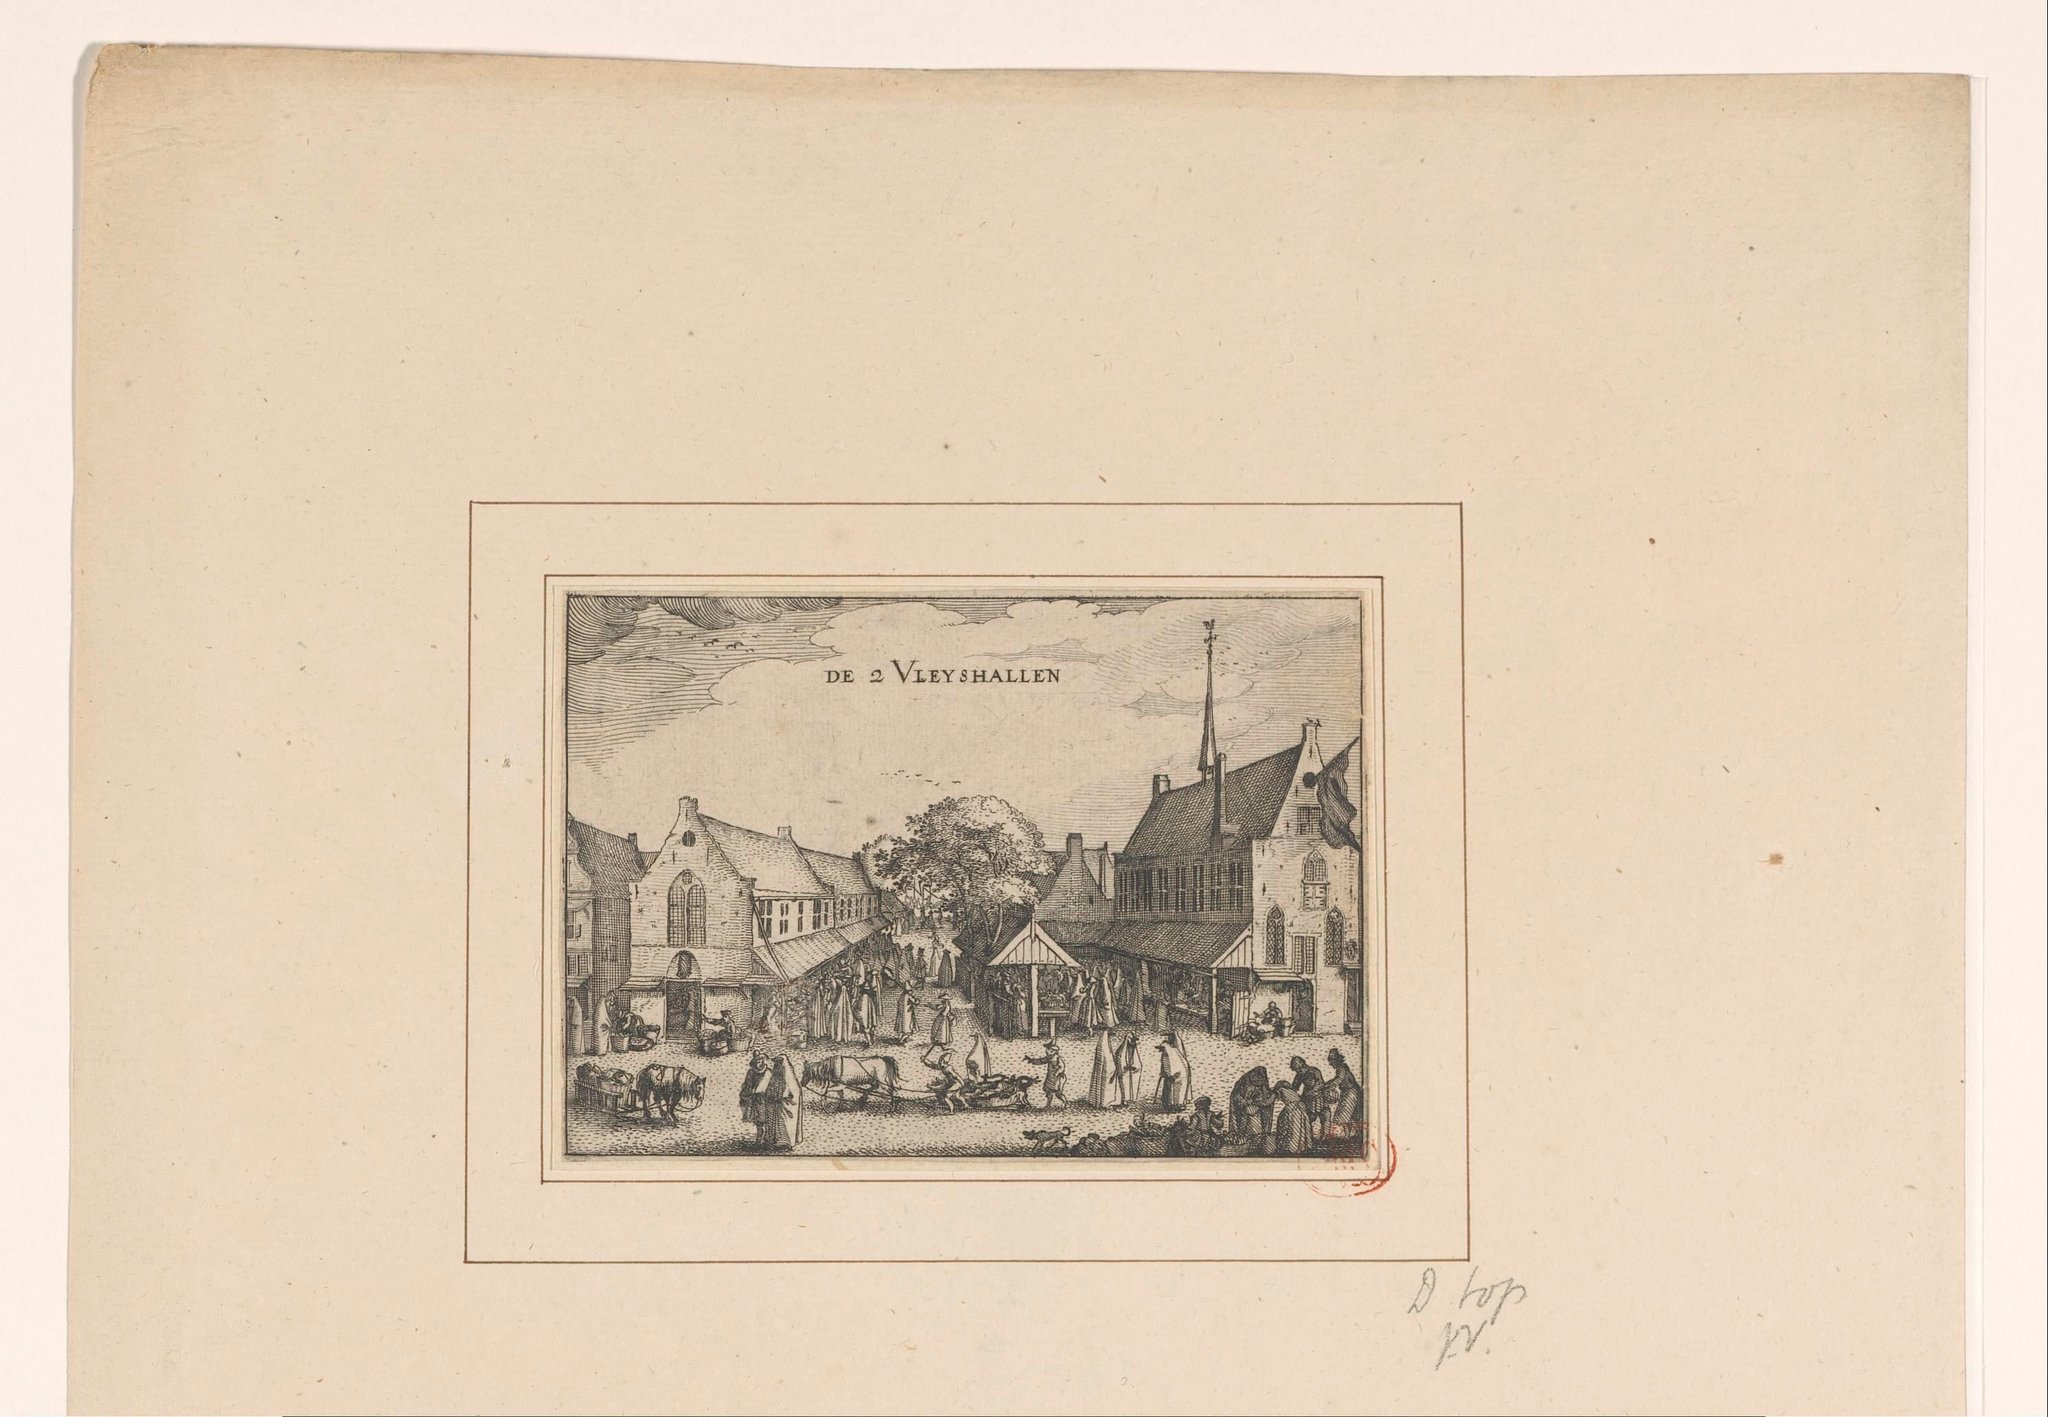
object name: print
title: Vier gebouwen in Amsterdam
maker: claes jansz. visscher (ii)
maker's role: draughtsman, print maker, publisher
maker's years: 1586-1652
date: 1611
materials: ink, paper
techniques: etching, pen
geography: amsterdam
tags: stall, booth (~ market), market, market-hall, street (+ city(-scape) with figures, staffage)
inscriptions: collector's mark: Lugt 195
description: Prent ook gebruikt als onderdeel van de rand van een profiel van Amsterdam, zie RP-P-AO-20-22. Let op: er is verwarring over wat de Grote en Kleine Vleeshal was. Dit komt doordat de kapel van het voormalige Sint-Pietersgasthuis (Grote Vleeshal) lager is, en dus kleiner oogt, dan de kapel van het voormalige Sint-Margaretheklooster (Kleine Vleeshal). Het gebouw voor de Grote Vleeshal werd echter verlengd en de ruimte die daar diende als vleeshal was groter dan de ruimte die in de kapel van het voormalige Sint-Margarethaklooster diende als vleeshal.